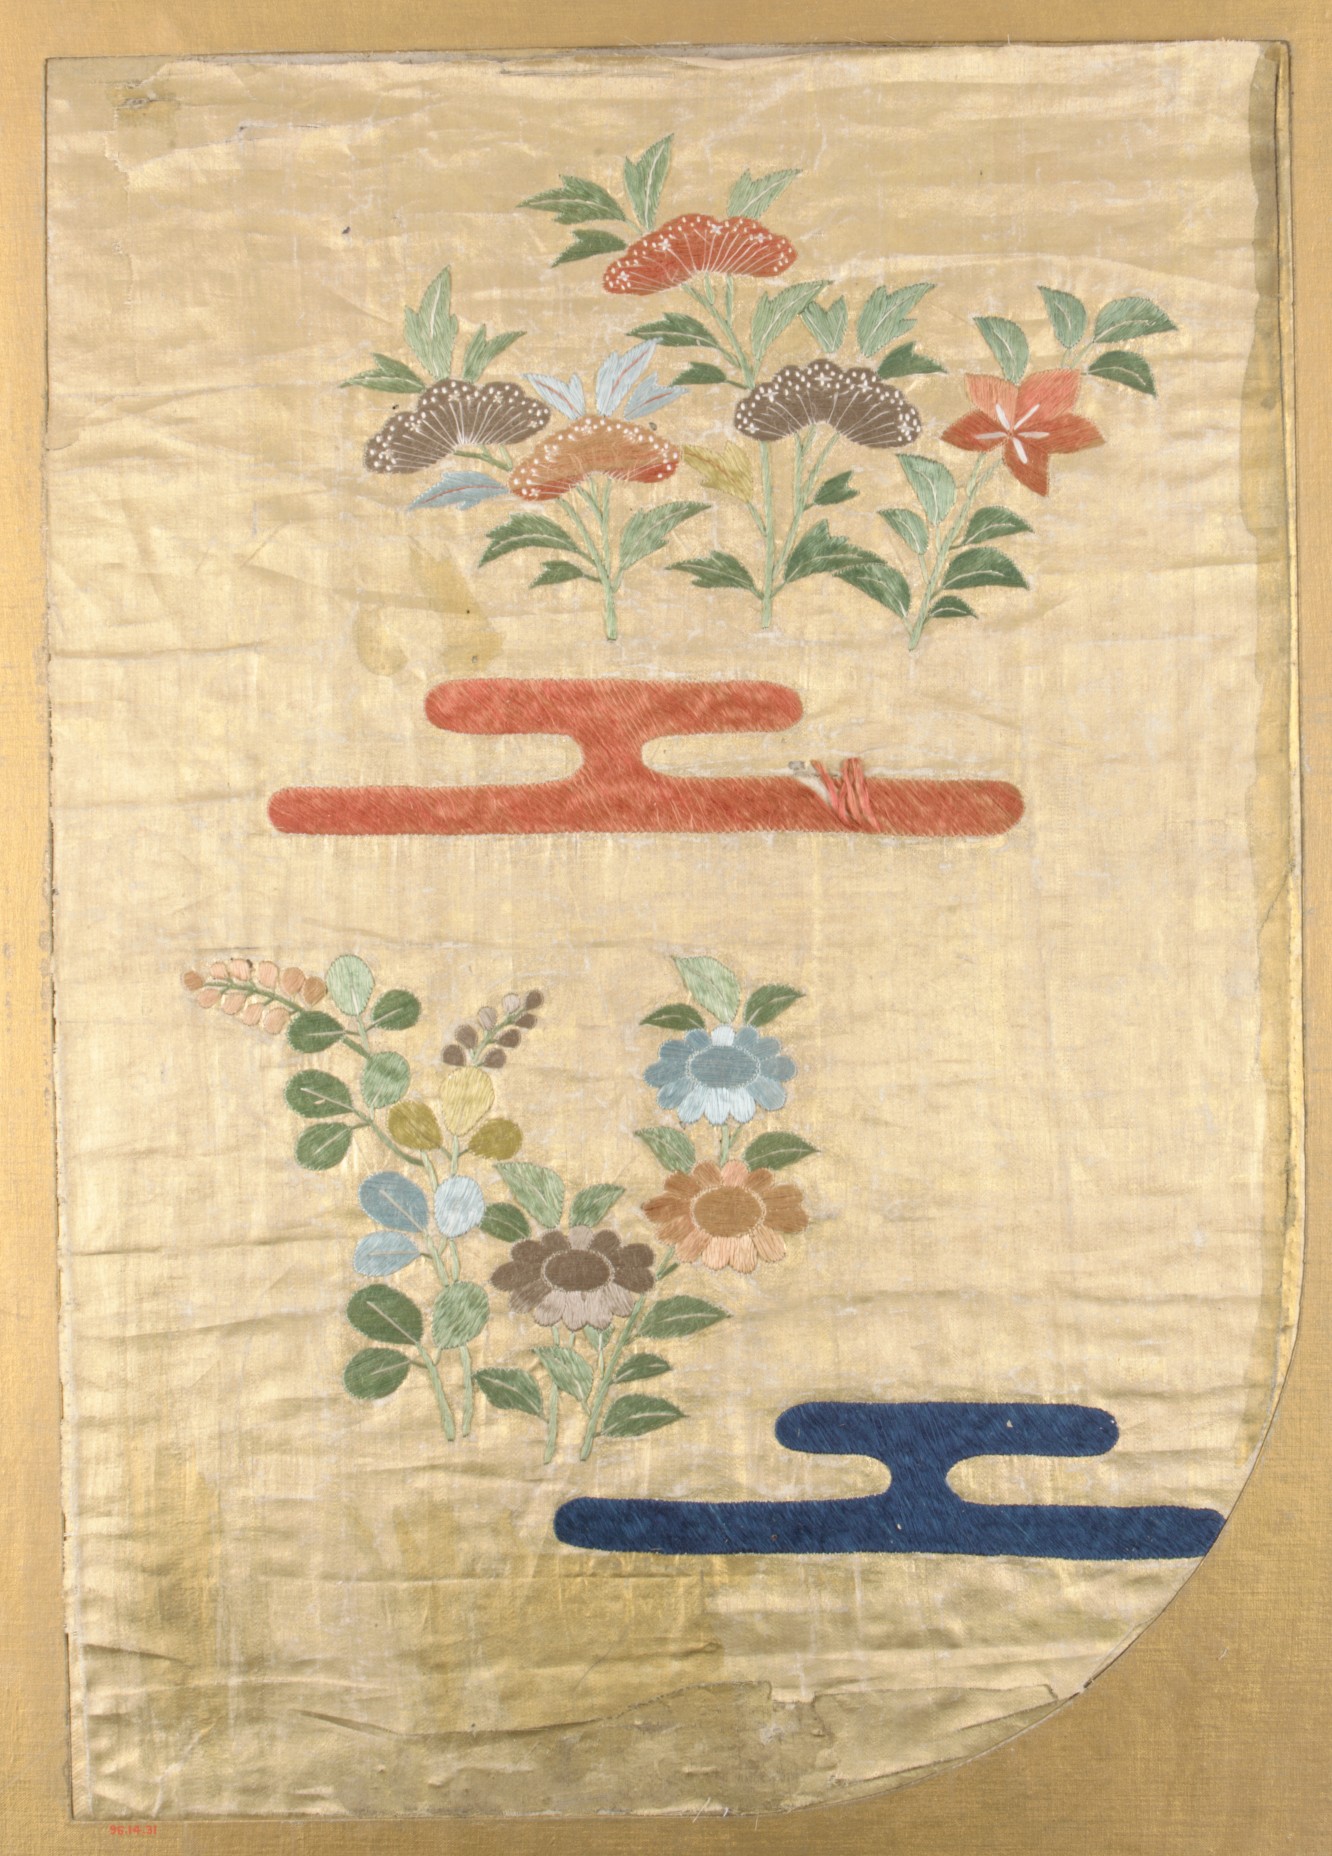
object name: piece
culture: japanese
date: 1701-1800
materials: silk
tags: leaves